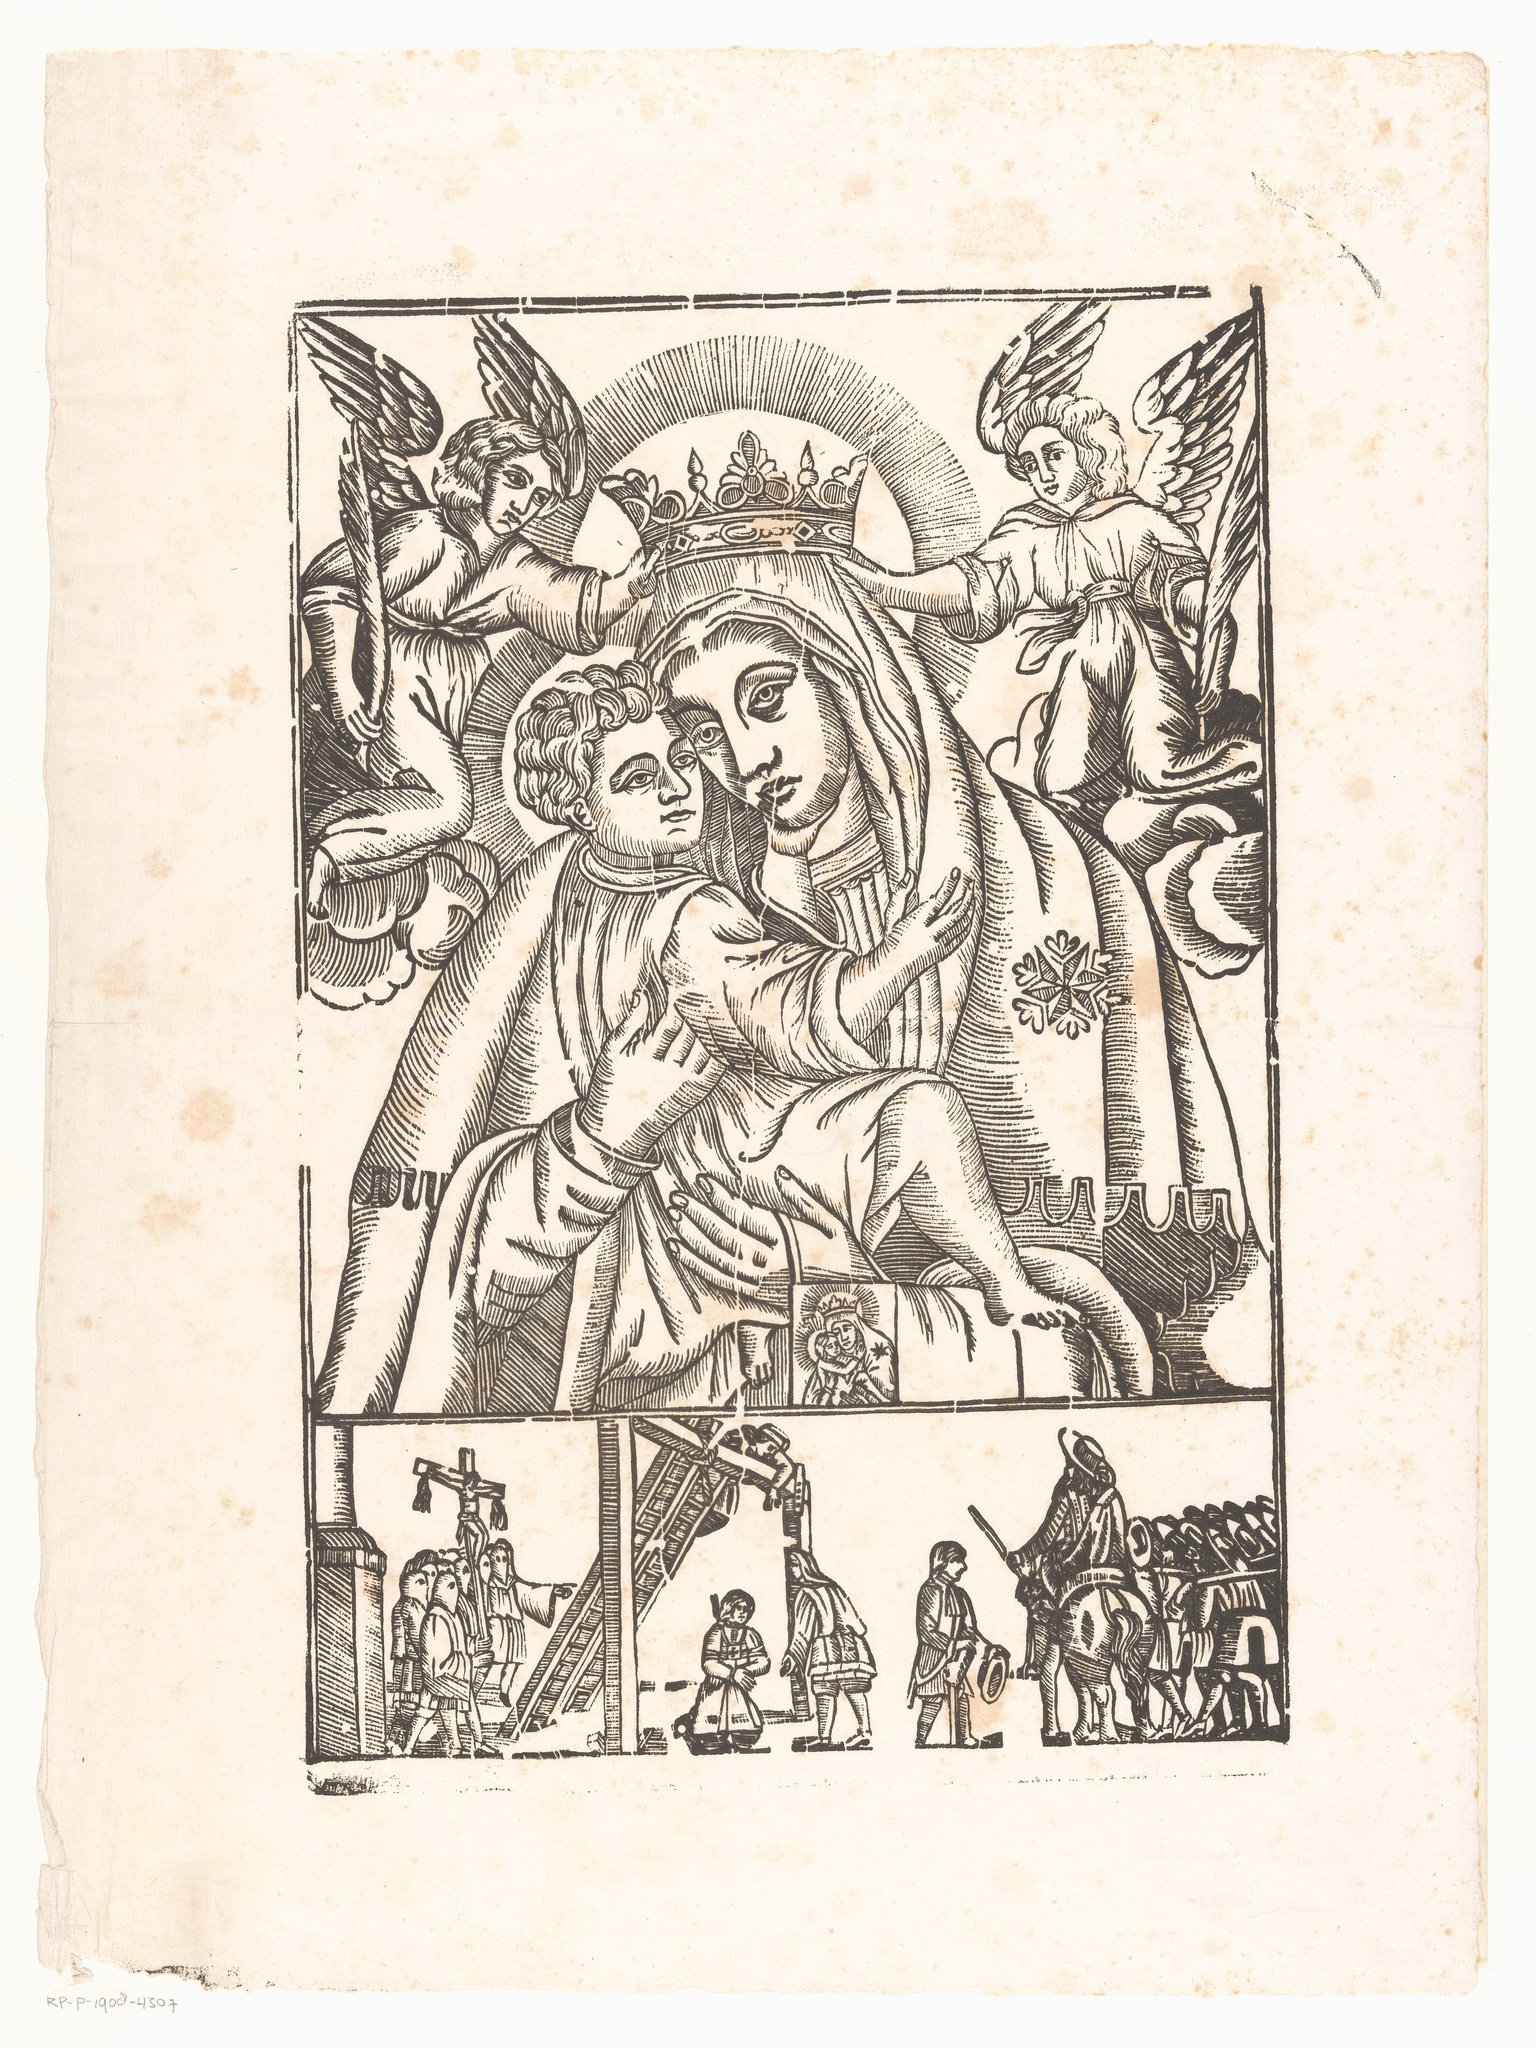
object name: print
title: Maria met Kind door twee engelen gekroond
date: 1500-1599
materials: paper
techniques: woodcut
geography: modena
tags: madonna: i.e. mary with the christ-child, angels crowning and/or bringing palm-branches, violent death by hanging (+ instrument of execution)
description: Boven Maria met het Christuskind, gekroond door twee engelen met palmtakken in de hand. Onder een scène met een groep gemaskerde figuren met een crucifix en de ophanging van een man.